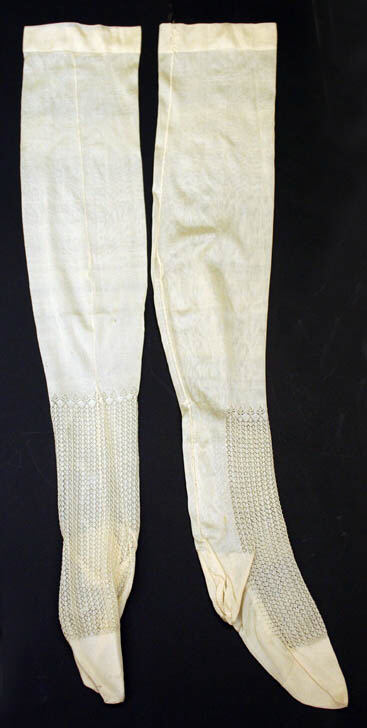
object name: stocking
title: Stockings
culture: american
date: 1890-1899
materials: silk